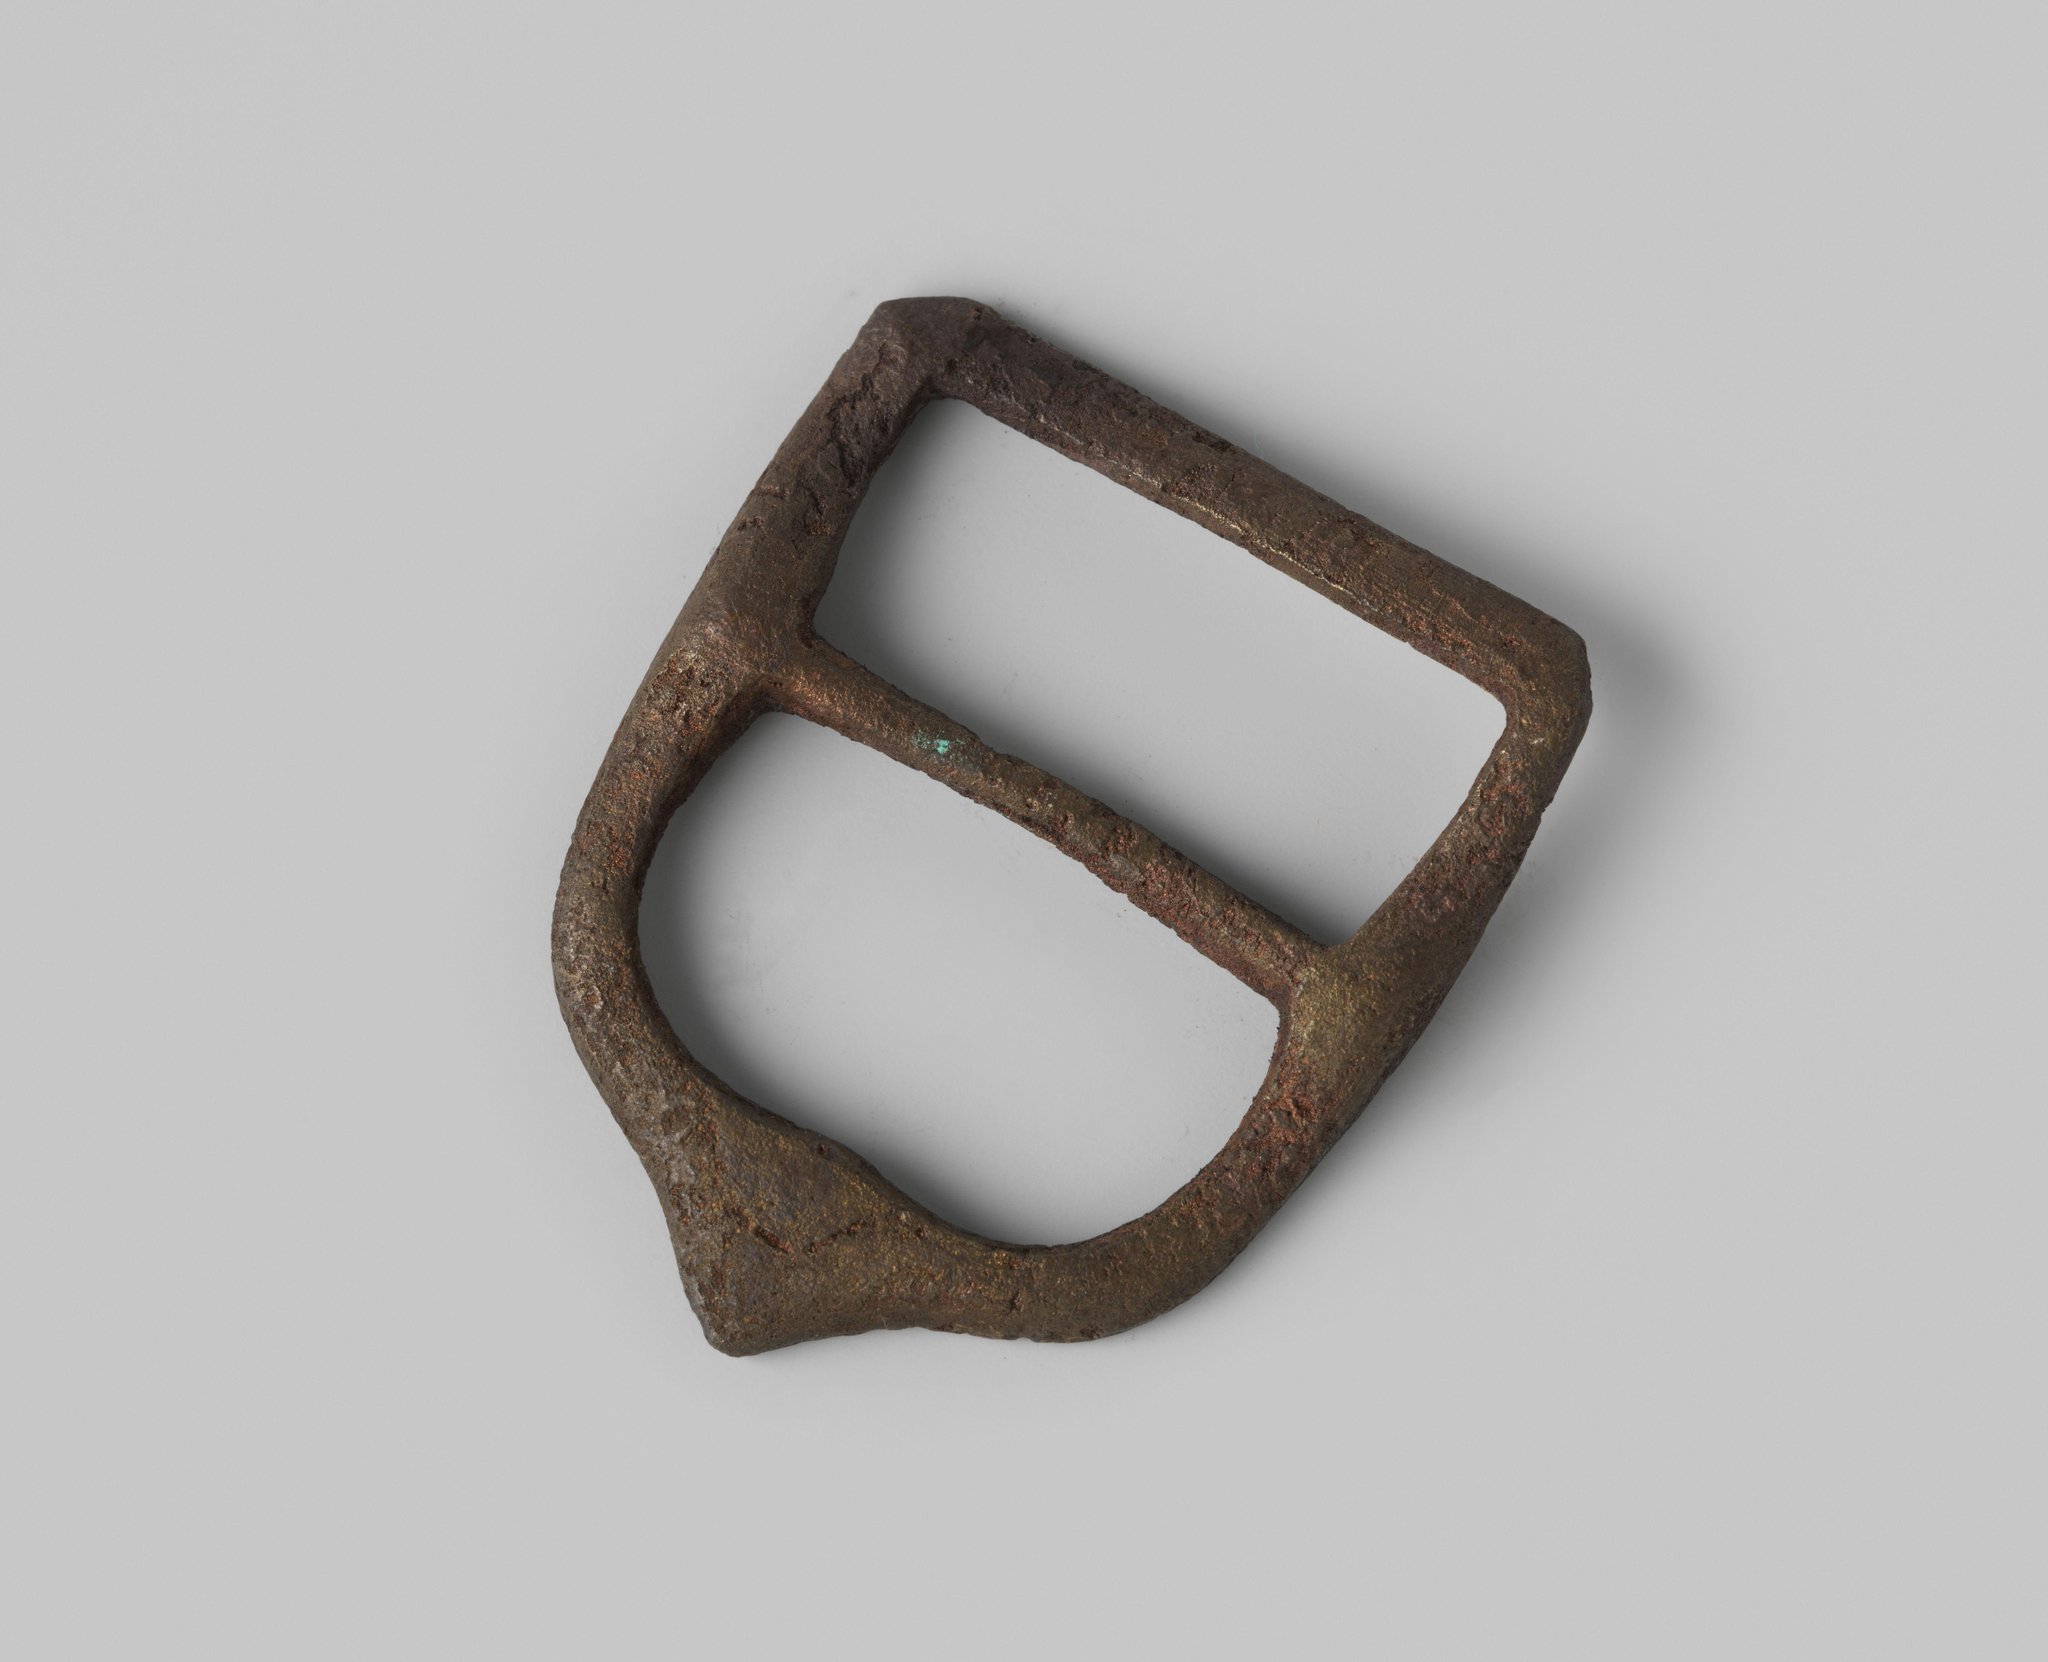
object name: belt buckle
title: Riemgesp uit het wrak van de Oost-Indiëvaarder Hollandia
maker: Anonymous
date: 1700-1743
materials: copper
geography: netherlands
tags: verenigde oostindische compagnie, hollandia (schip), annet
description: D-shaped with pointed side, ring, id. NG-1980-27-H-384, belt buckle.